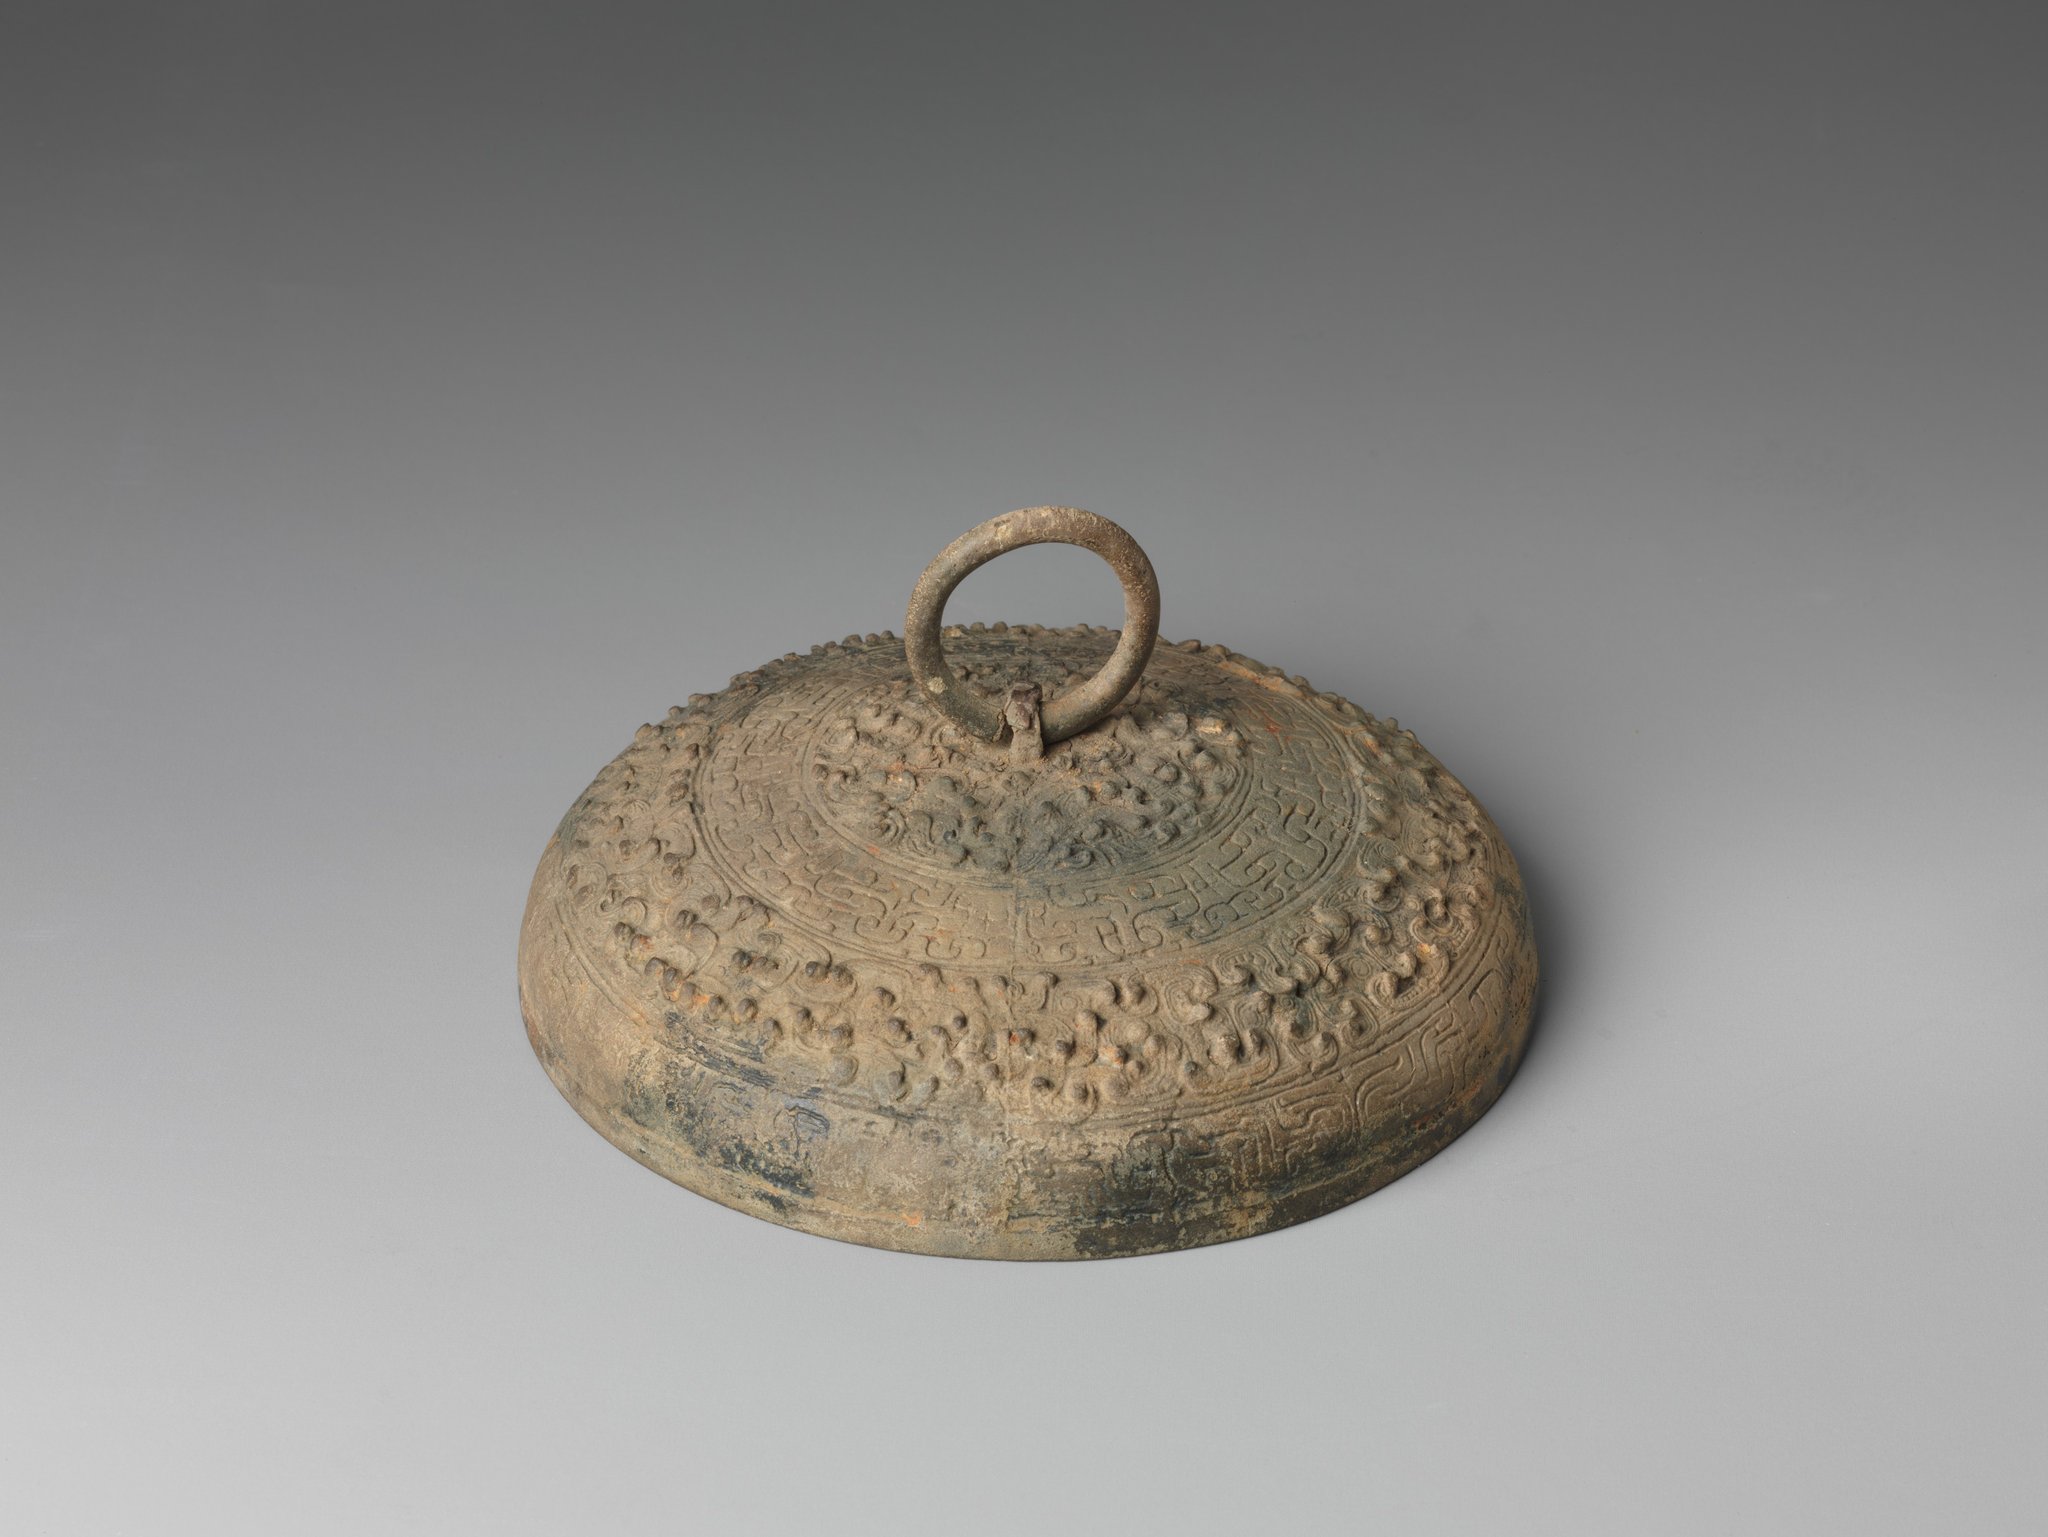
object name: vessel with cover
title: Cover for Ritual Vessel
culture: chinese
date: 770-256 BCE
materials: bronze